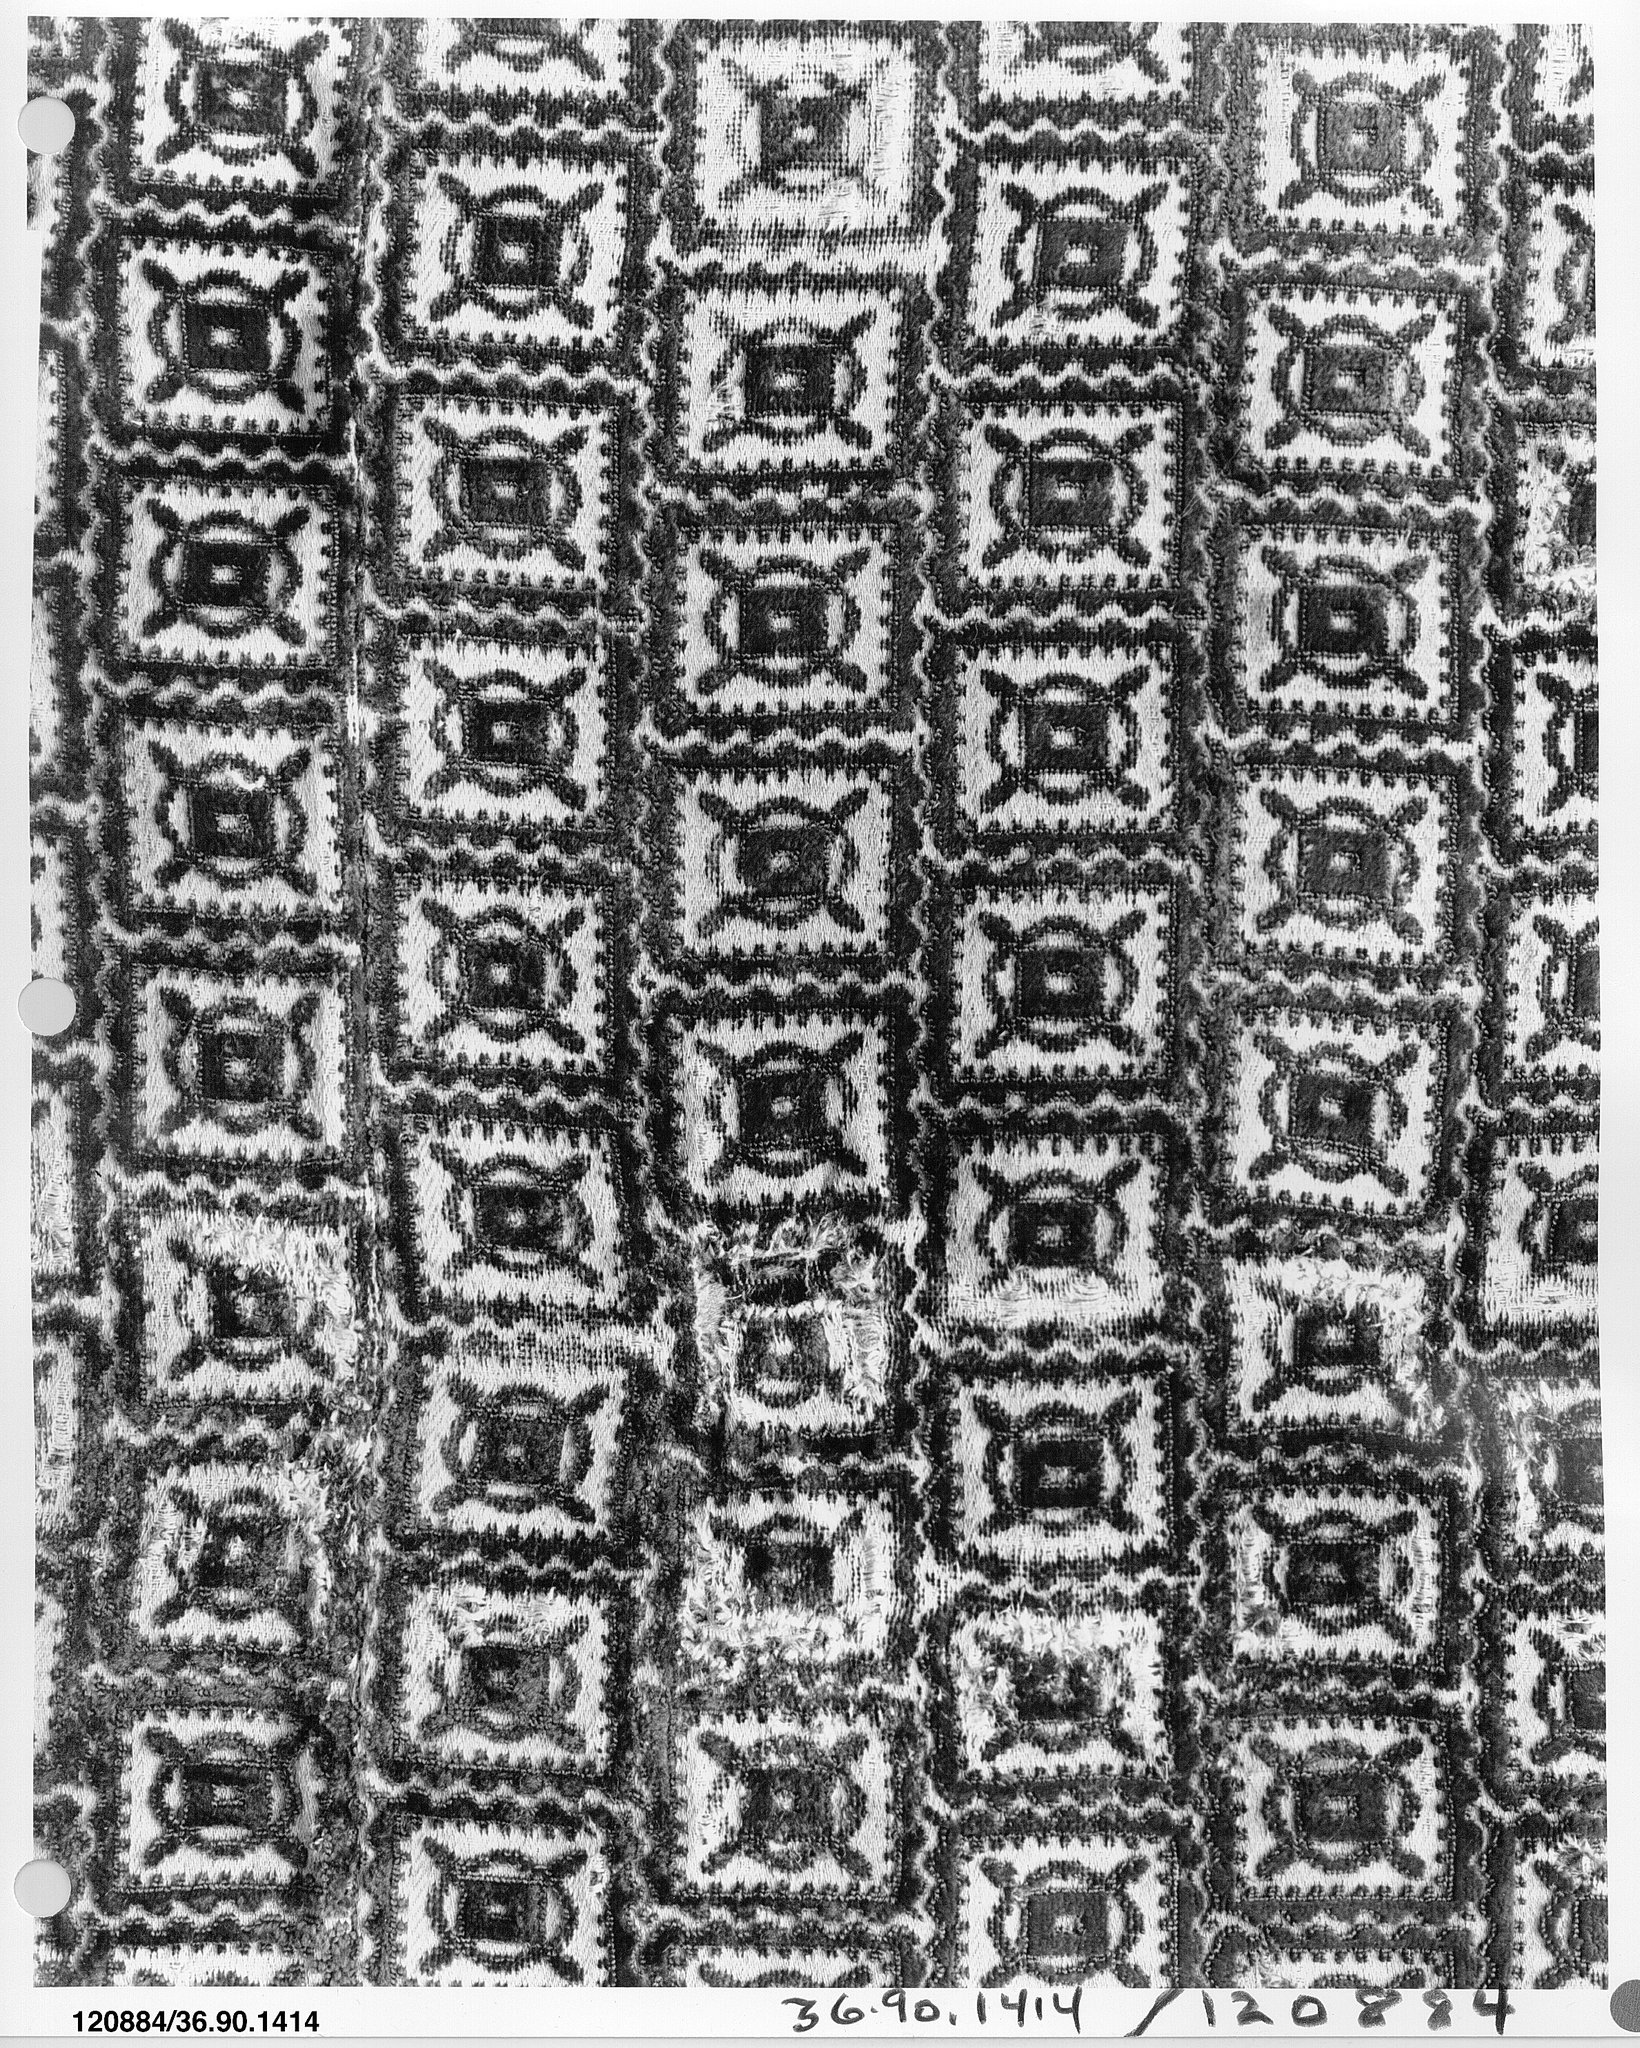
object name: piece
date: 1501-1700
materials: silk